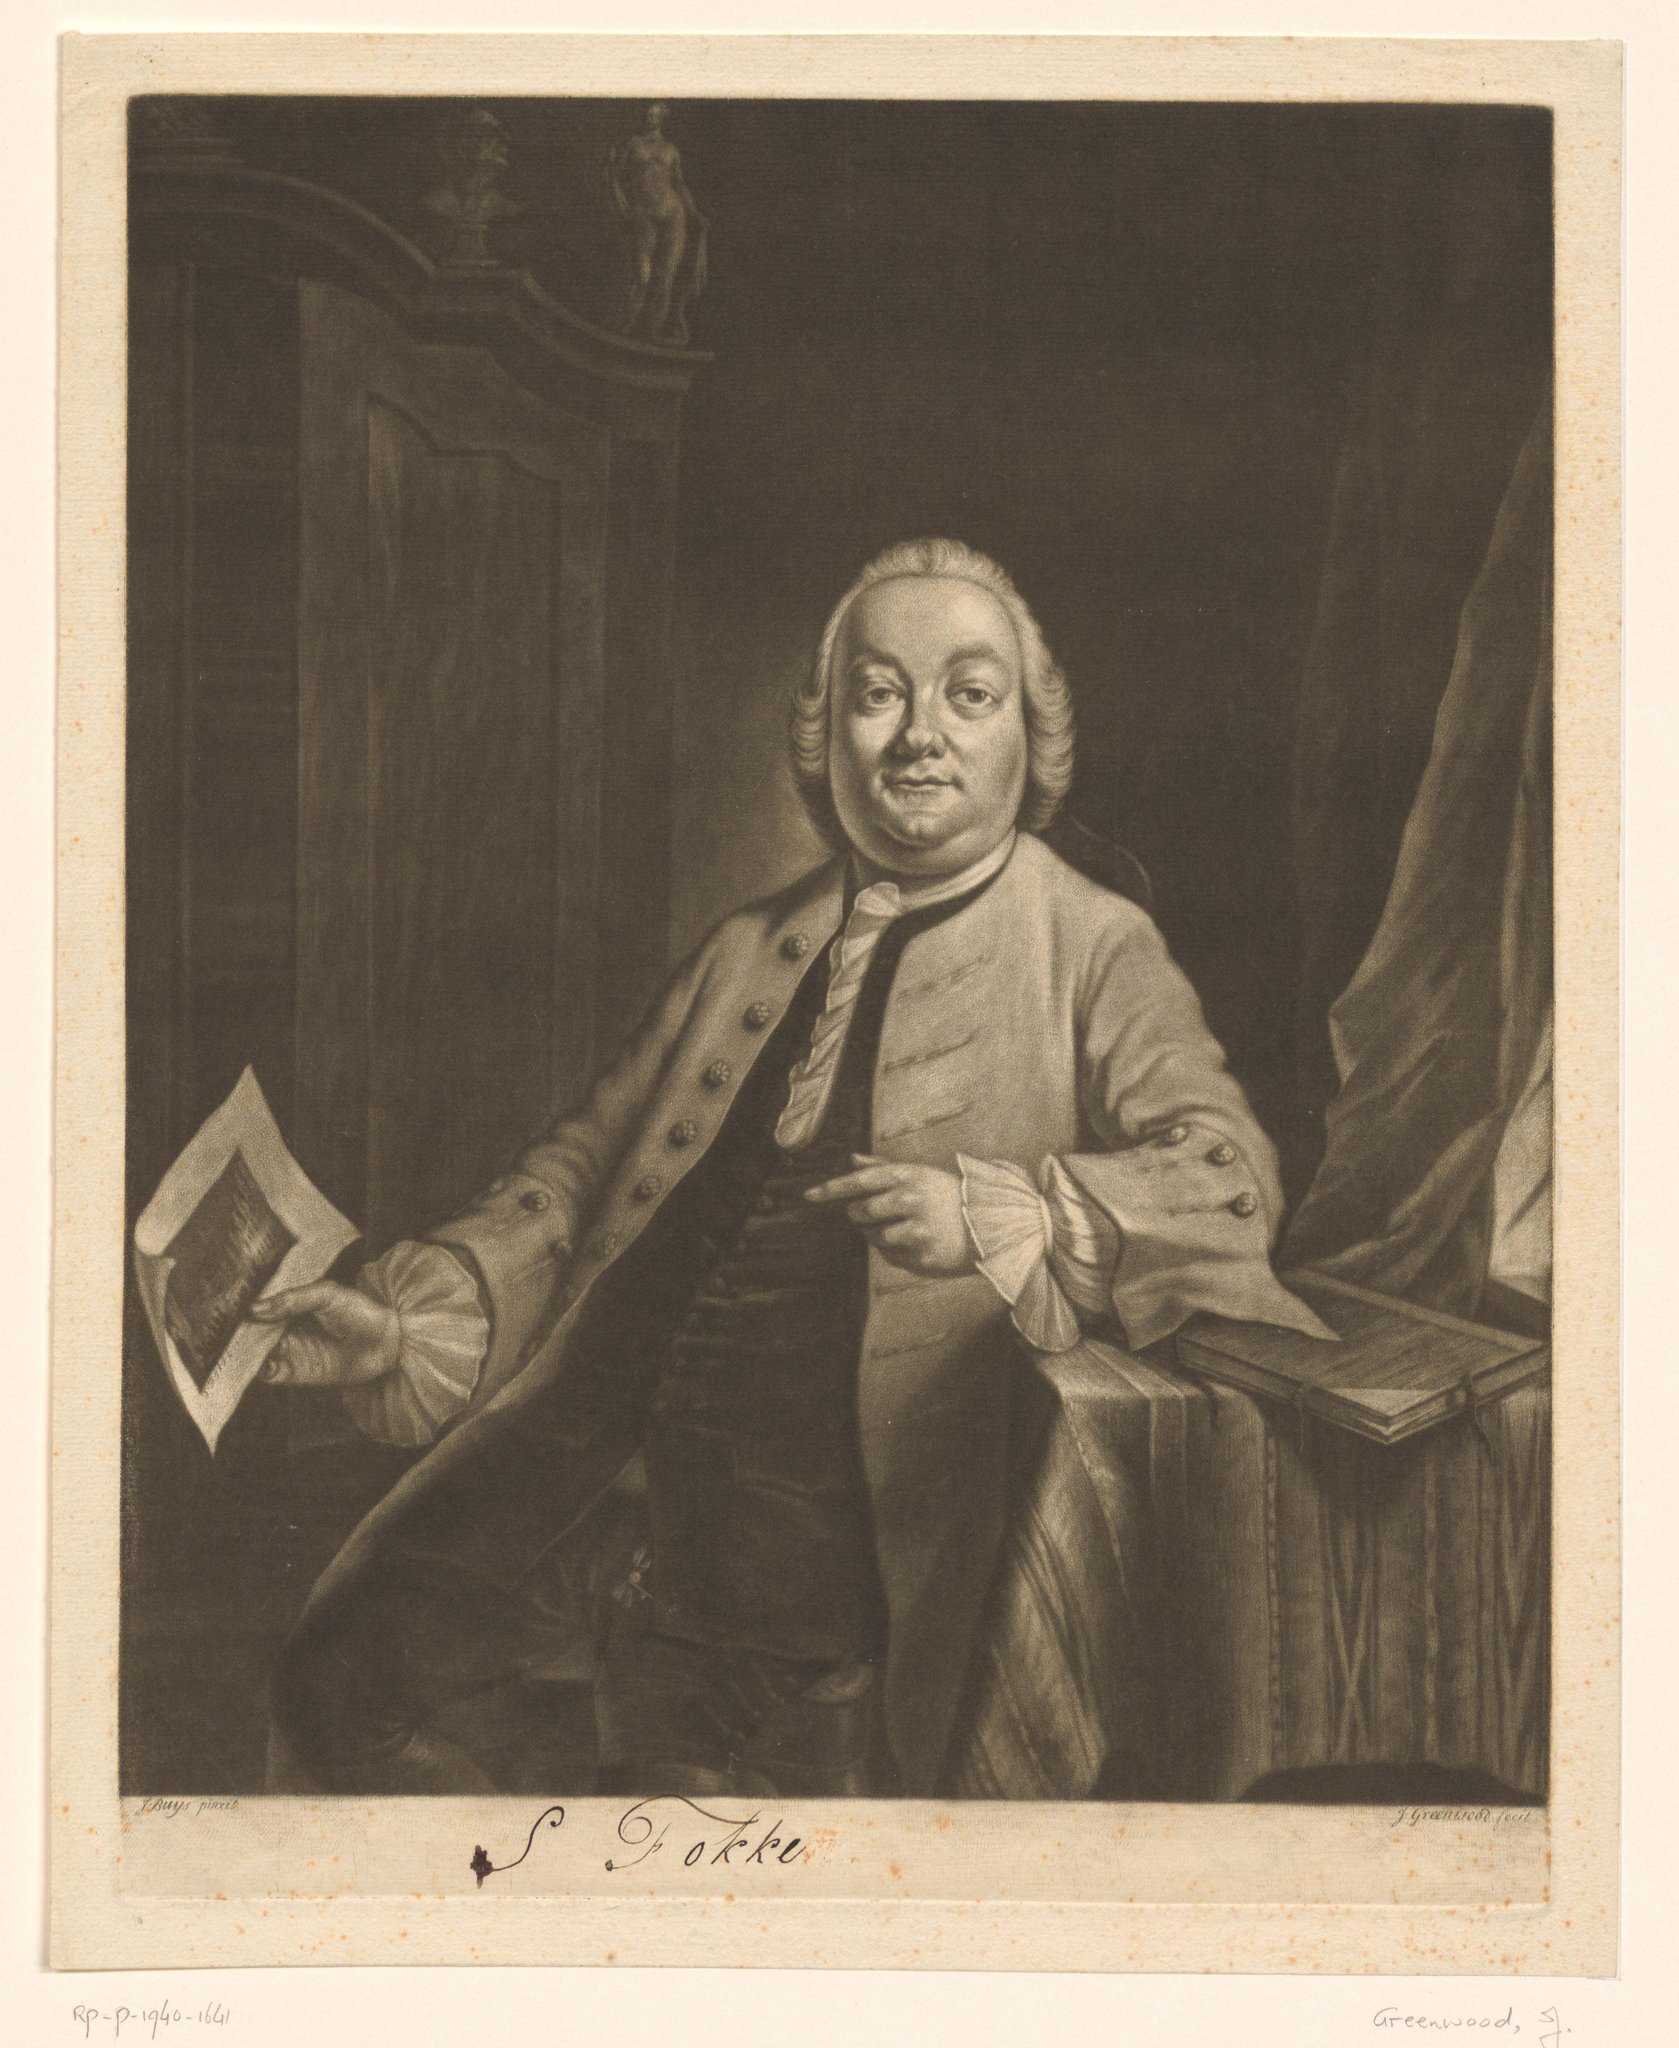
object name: print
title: Portret van Simon Fokke met in zijn hand de prent van de plundering van het huis van Gerrit Hagedooren, 1751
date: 1751-1792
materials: paper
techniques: mezzotint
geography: northern netherlands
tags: amsterdam, simon fokke, engraver, etcher, historical persons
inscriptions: collector's mark: Lugt 2166, inscription: ‘S Fokke’, collector's mark: Lugt 2760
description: Portret van de prentmaker Simon Fokke zittend aan een tafel. Hij houdt in zijn rechterhand een afdruk van de prent van de plundering van het huis van de wijnkoper Gerrit Hagedooren (Hagedoorn) in de Bierstraat te Rotterdam in de avond van 17 augustus 1751.